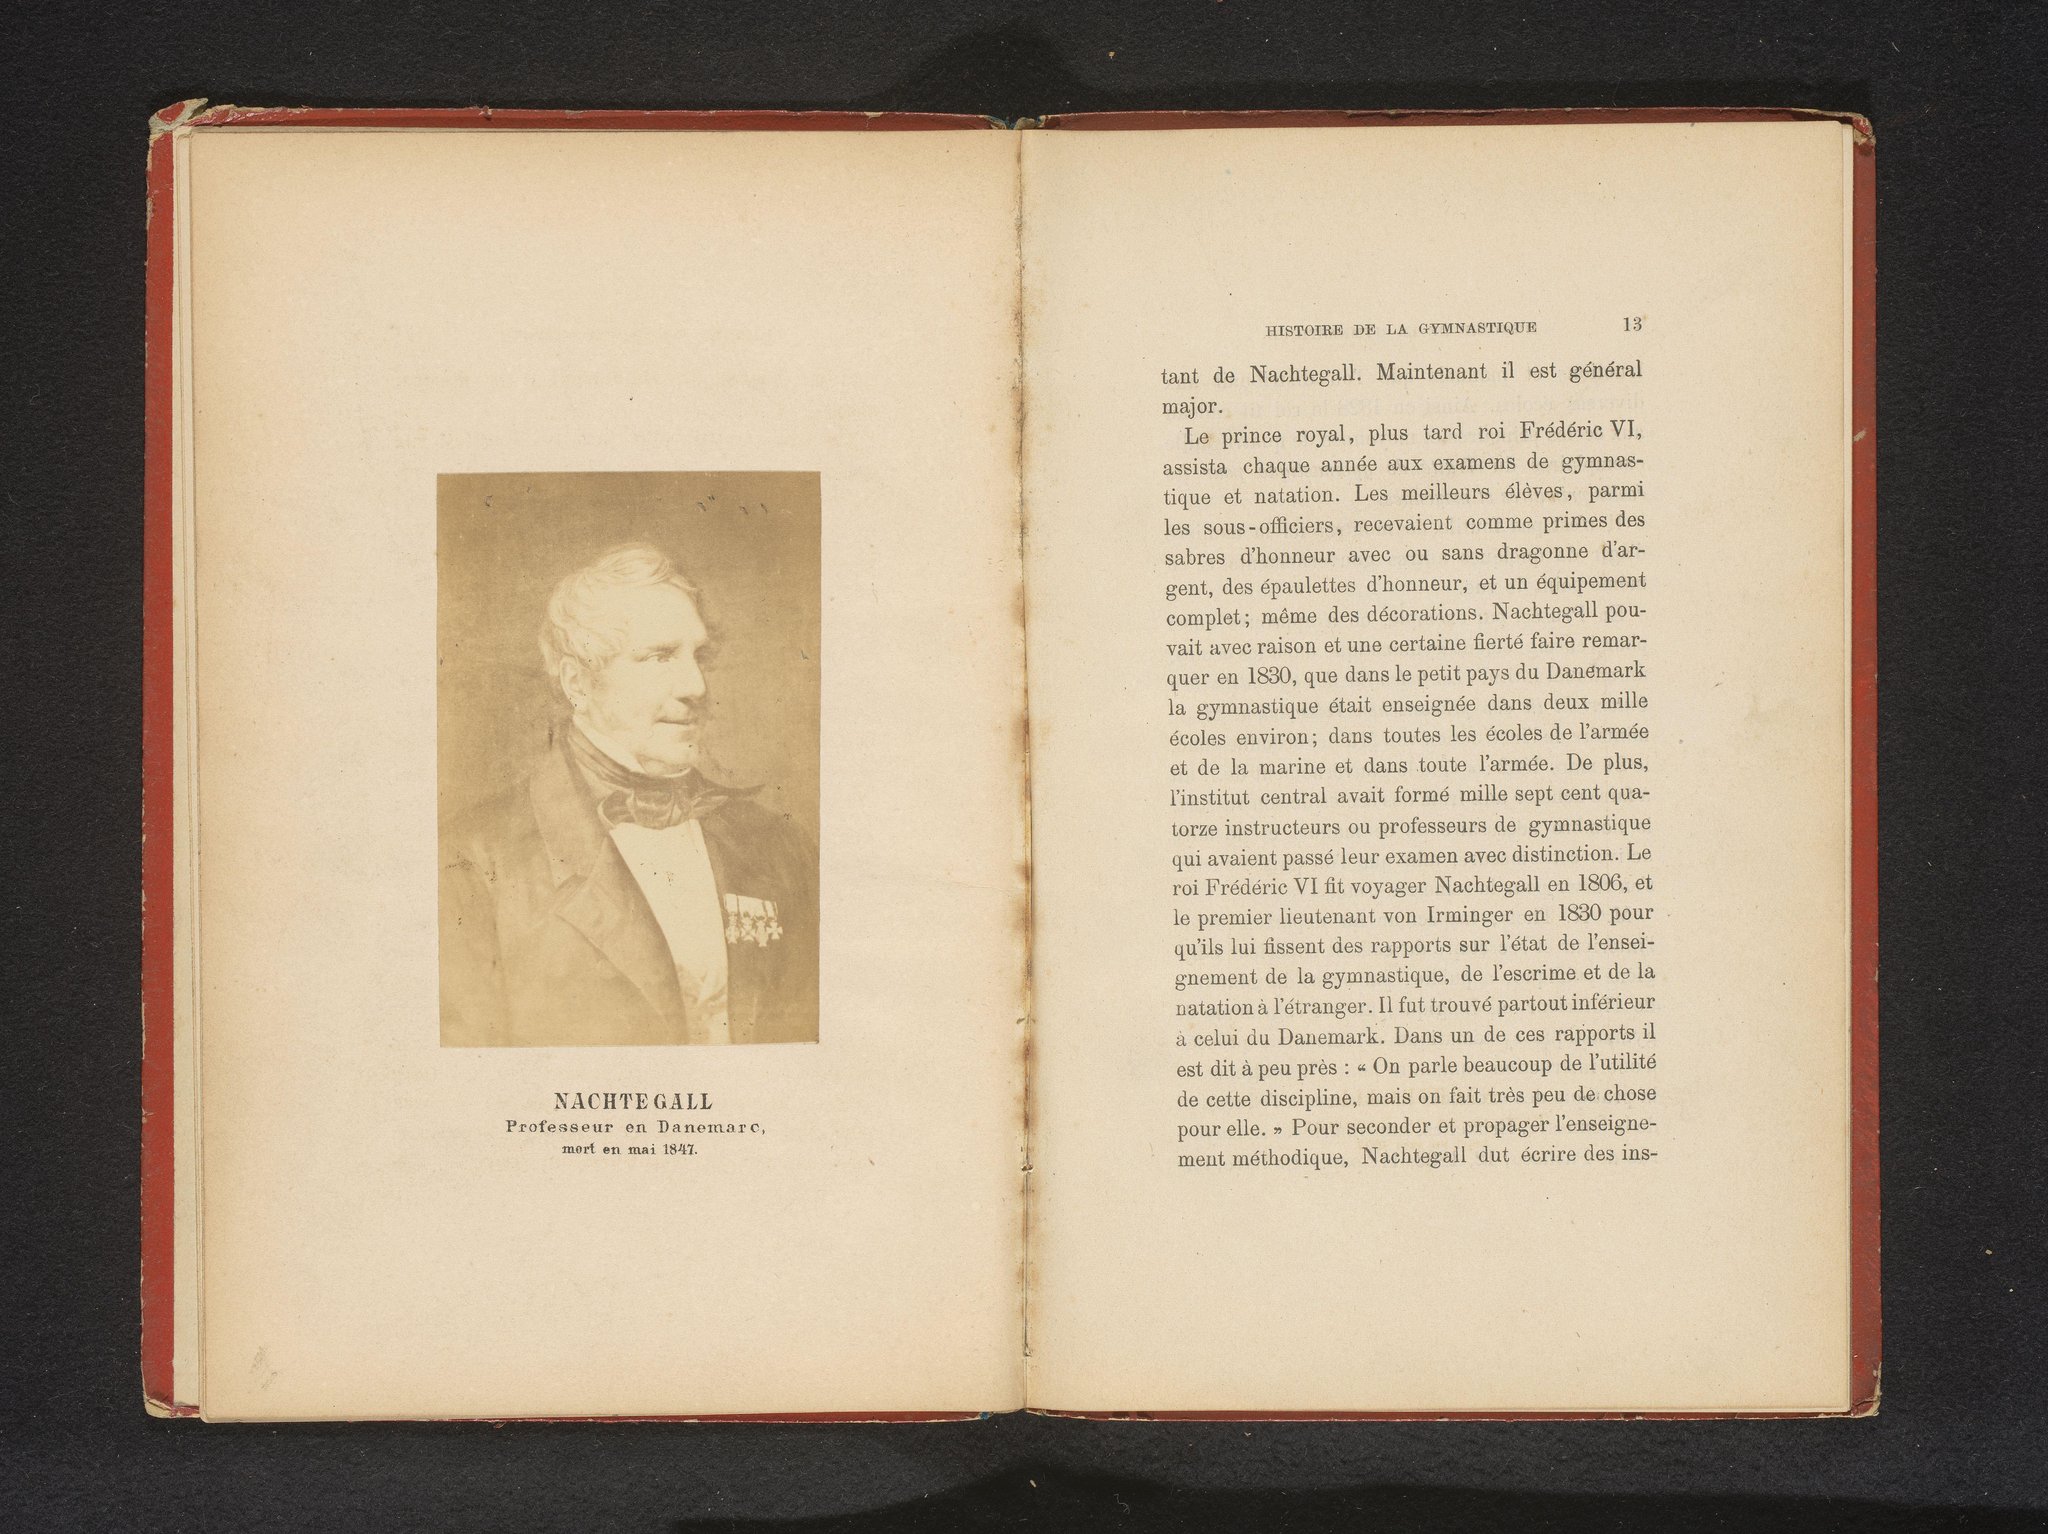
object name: photograph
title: Fotoreproductie van een portret van Franz Nachtegall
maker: Anonymous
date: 1867-1877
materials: photographic support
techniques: albumen print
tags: professor